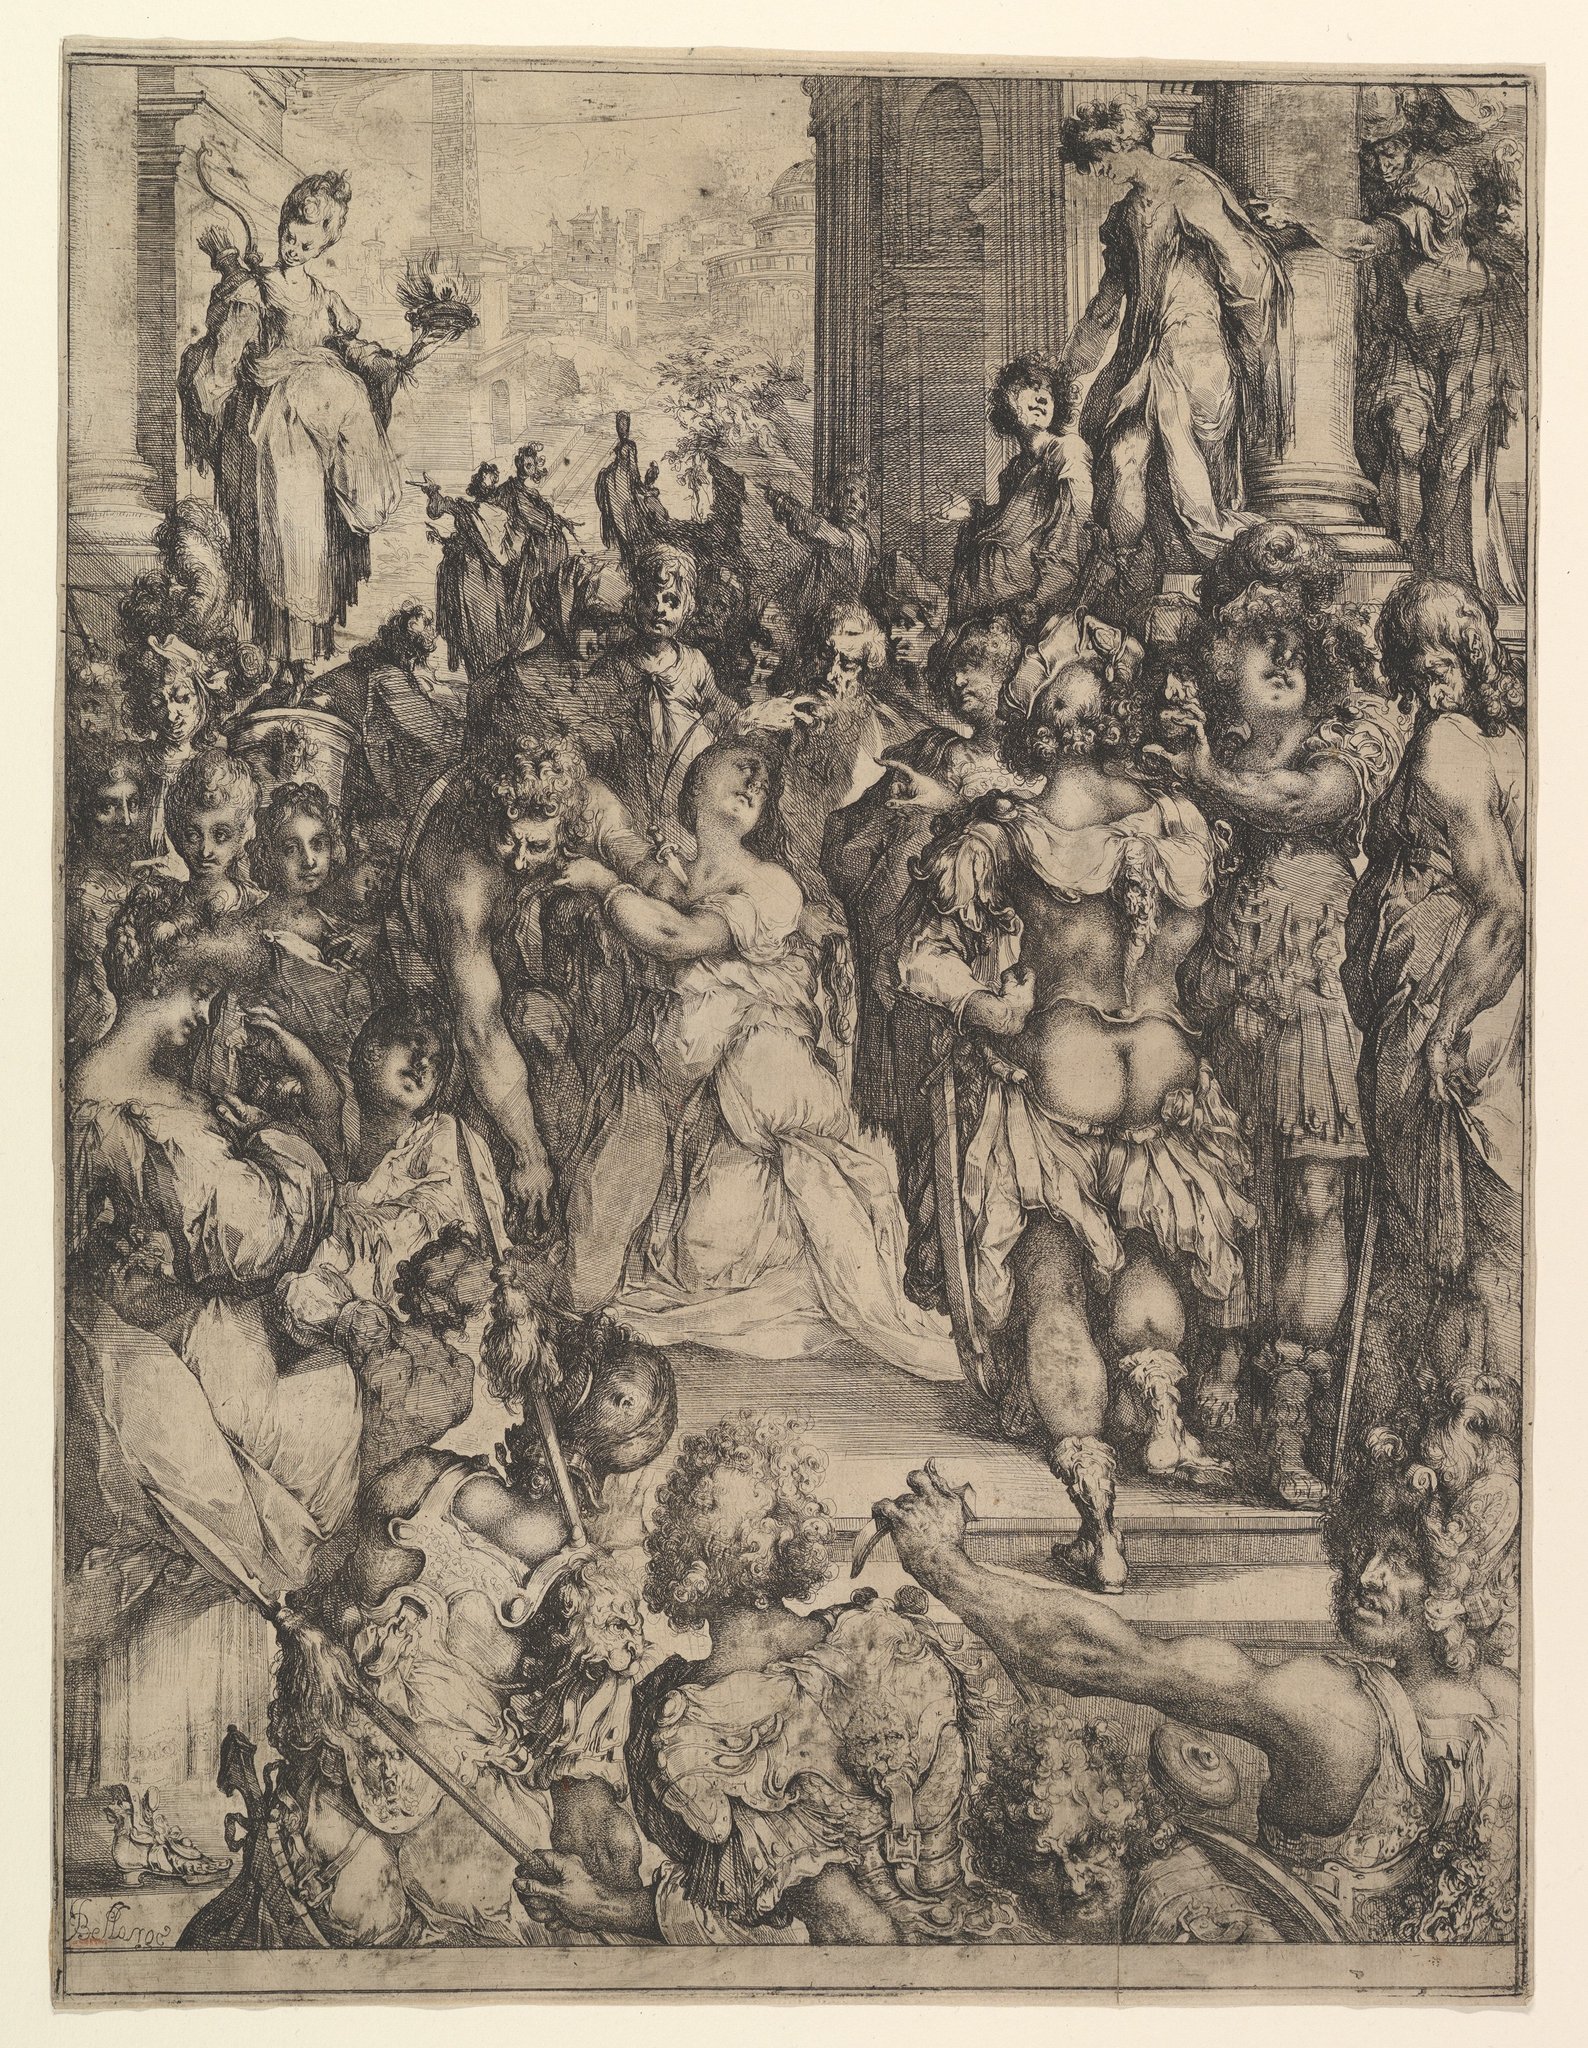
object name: print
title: The Martyrdom of Saint Lucy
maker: jacques bellange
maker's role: artist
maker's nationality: french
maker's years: 1575-1616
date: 1575-1616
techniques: etching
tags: human figures,saints